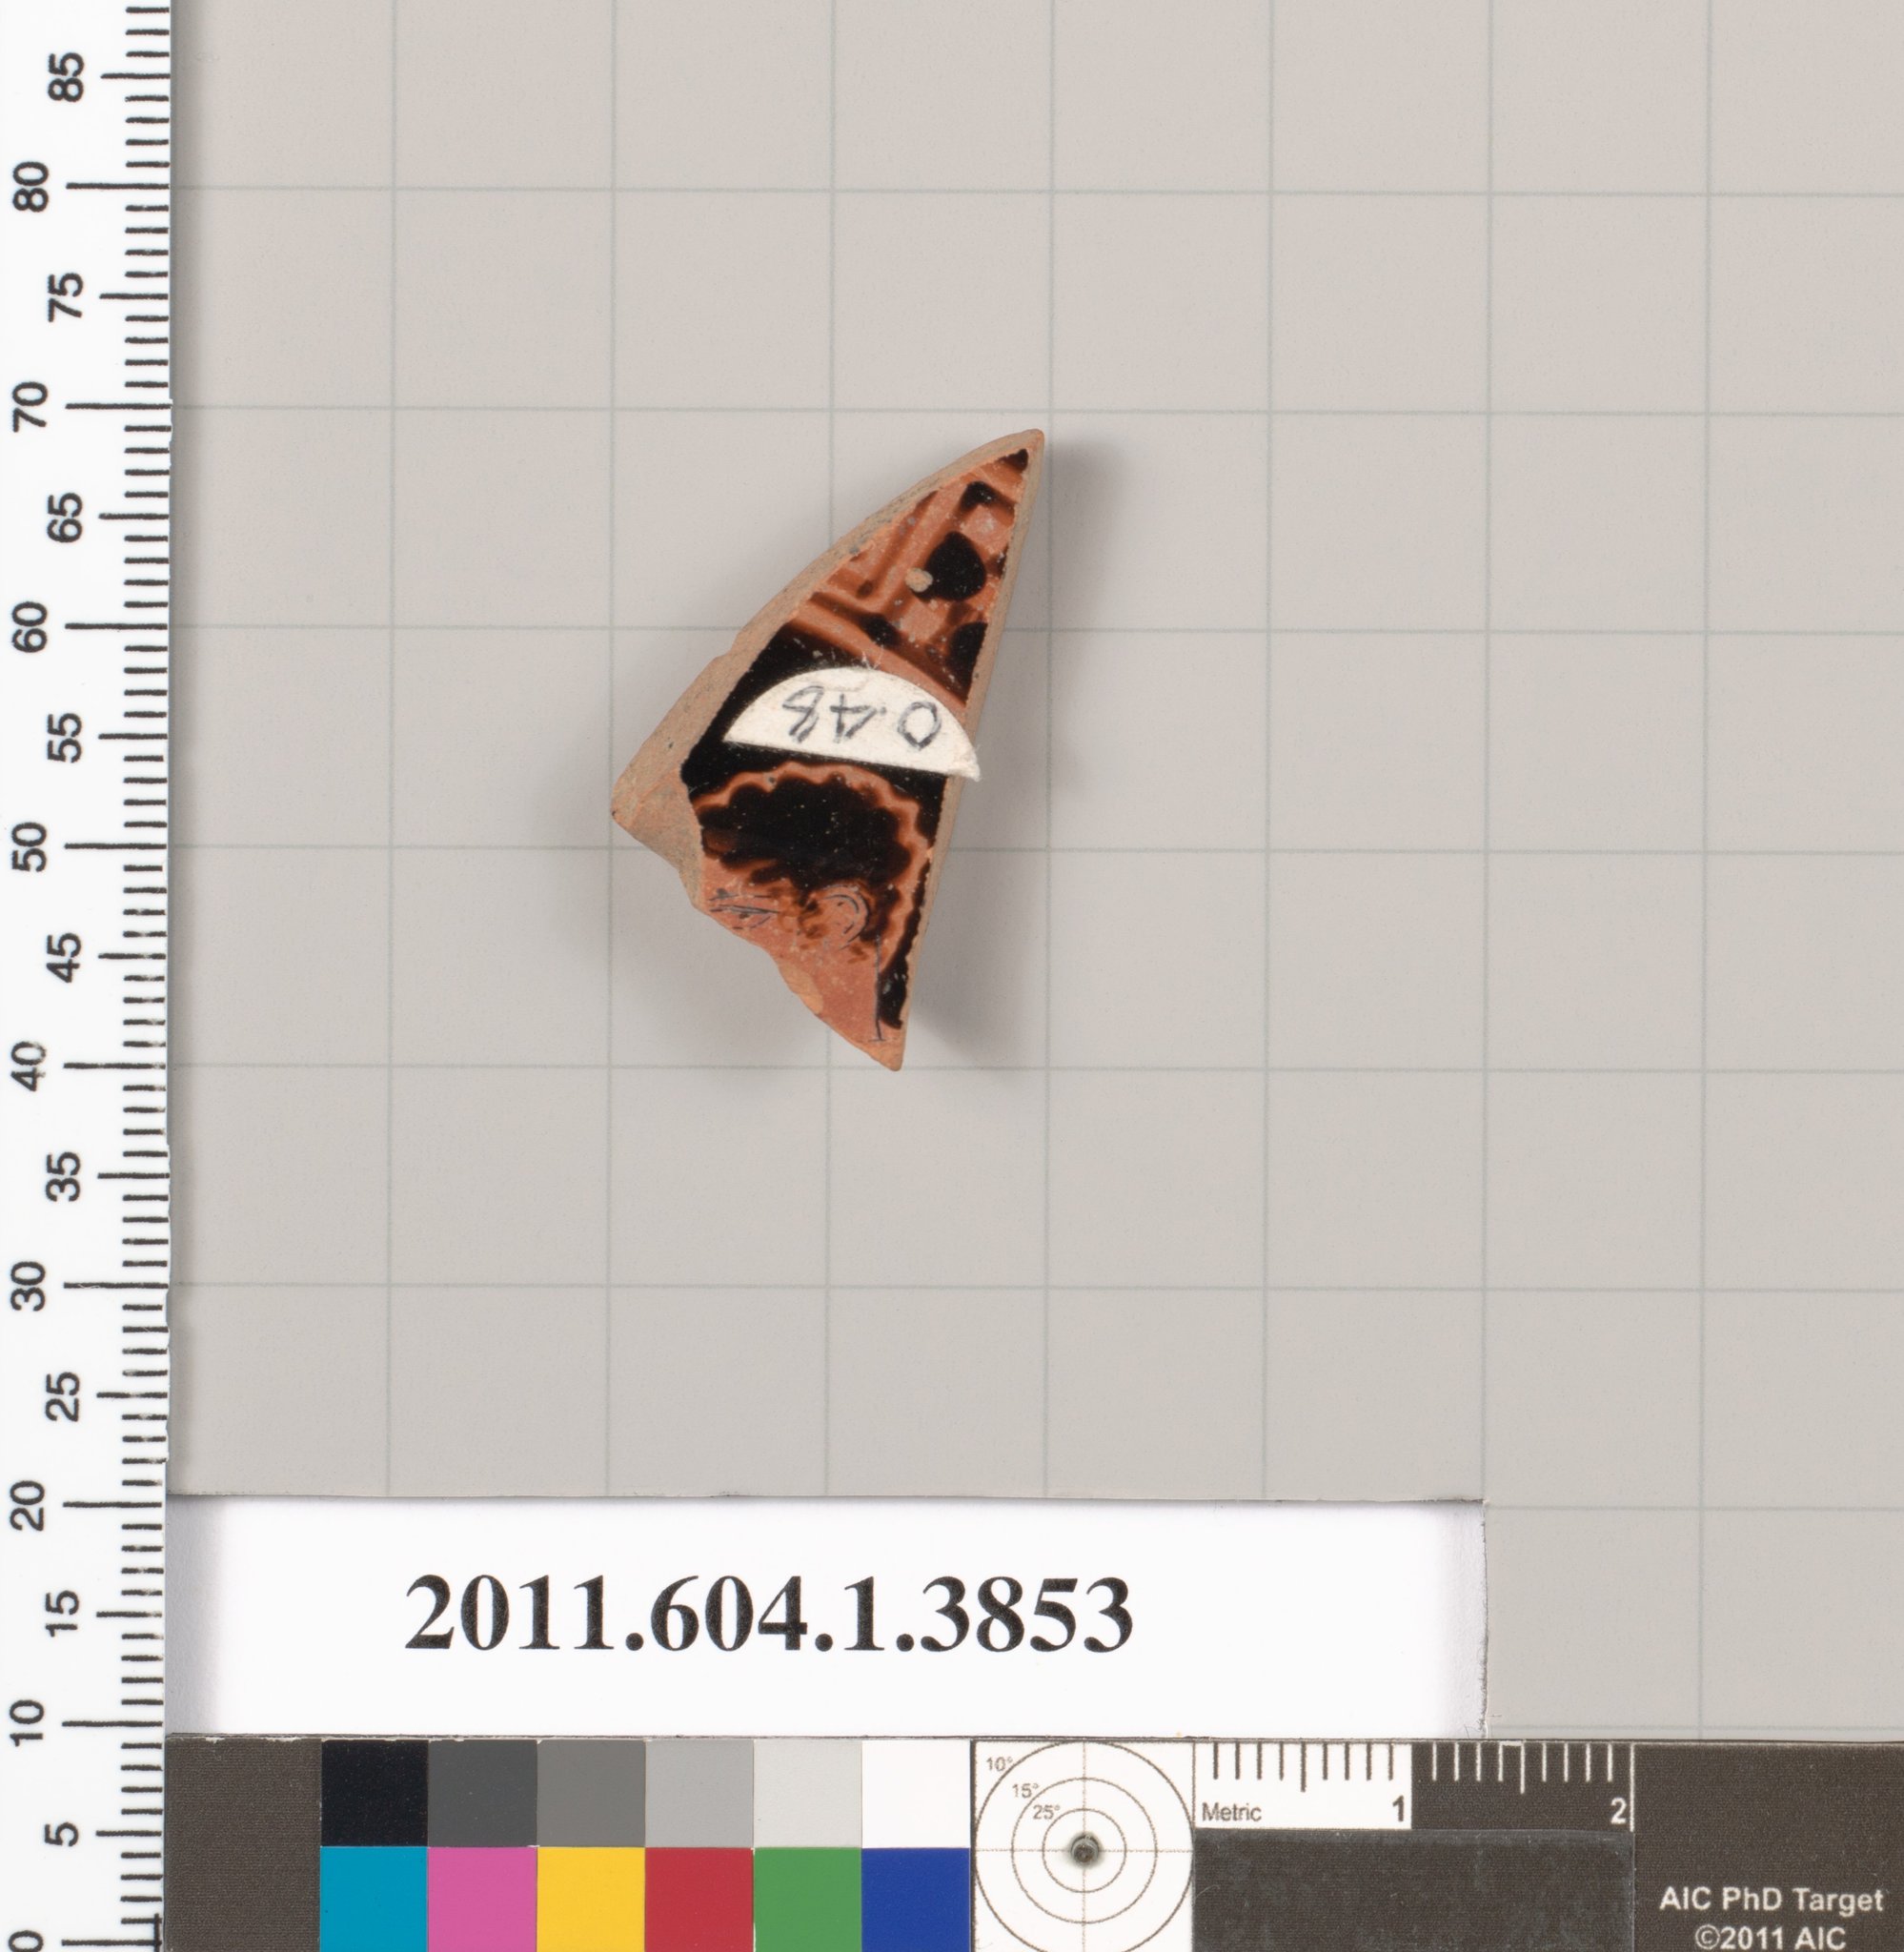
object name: kylix fragment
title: Terracotta fragment of a kylix (drinking cup)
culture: greek, attic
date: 460-450 BCE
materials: terracotta